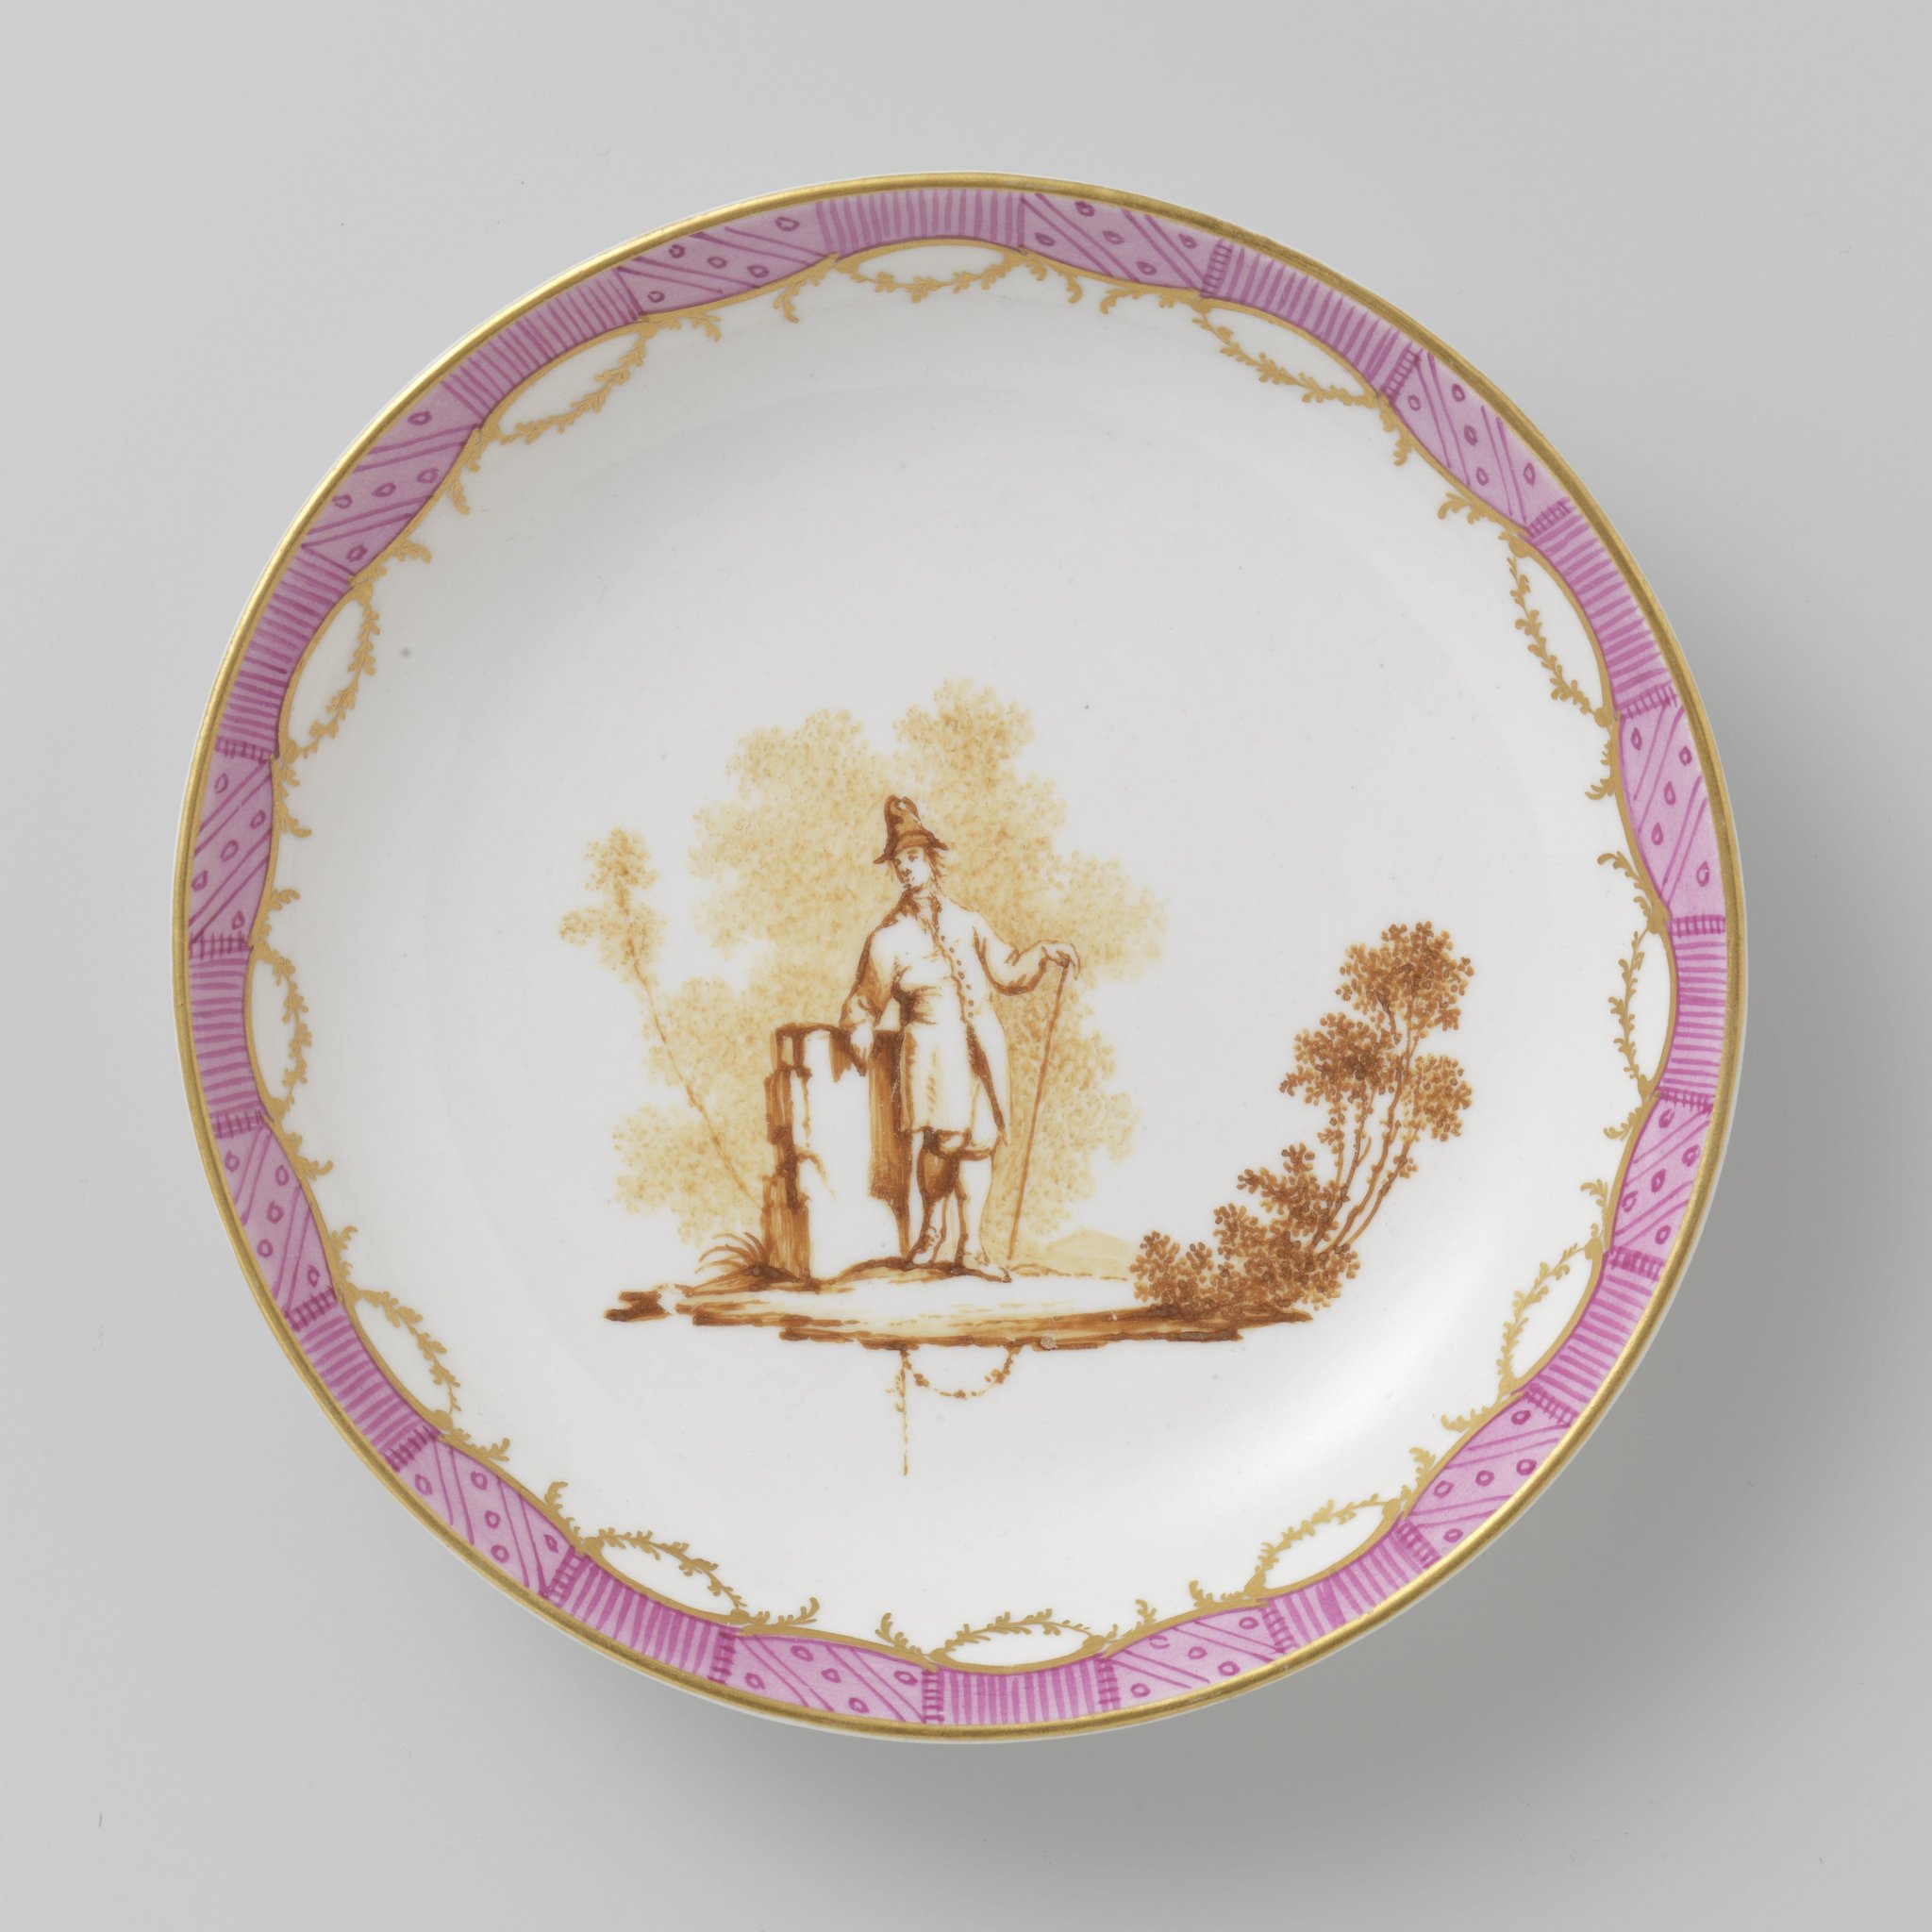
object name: platter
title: Tea service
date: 1774-1778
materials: porcelain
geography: loosdrecht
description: Tea services represented a significant part of the production of the Loosdrecht porcelain factory. On display here are a teapot, milk jug and sugar bowl along with other less familiar parts of a tea service, such as a slop bowl, which is used to rinse and warm the cups between two ‘courses’, and a drip catcher (pattipan), which catches the drips from the spout of the teapot.